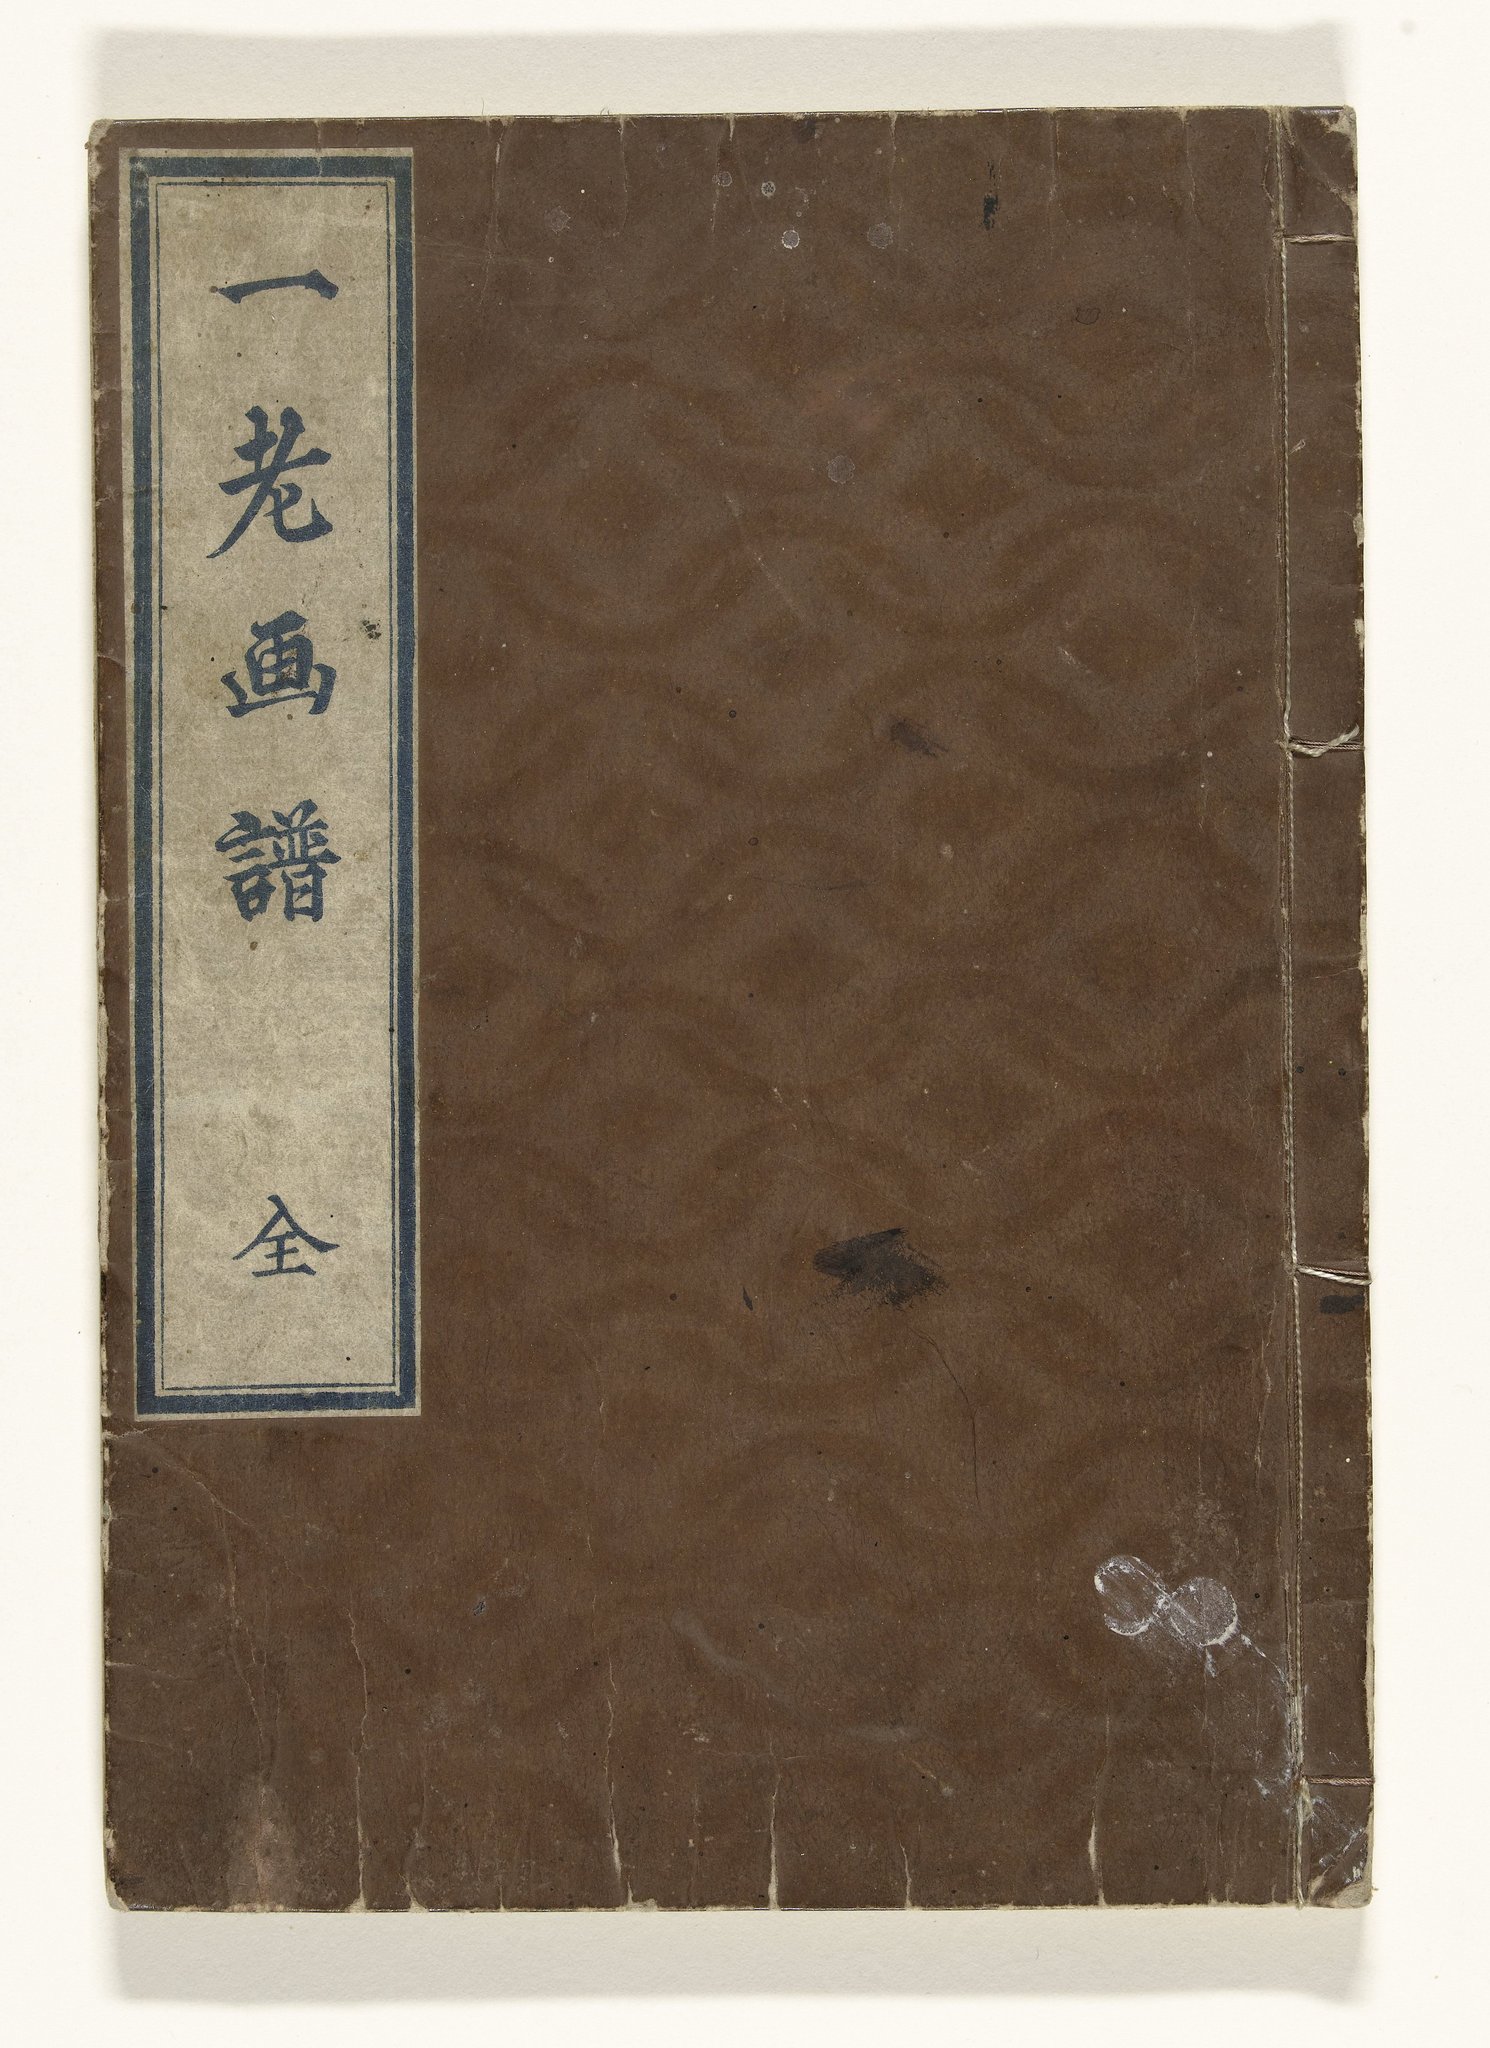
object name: book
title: Ichiro gafu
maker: yashima gakutei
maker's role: print maker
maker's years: 1786-1868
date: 1823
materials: paper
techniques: woodcut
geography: japan